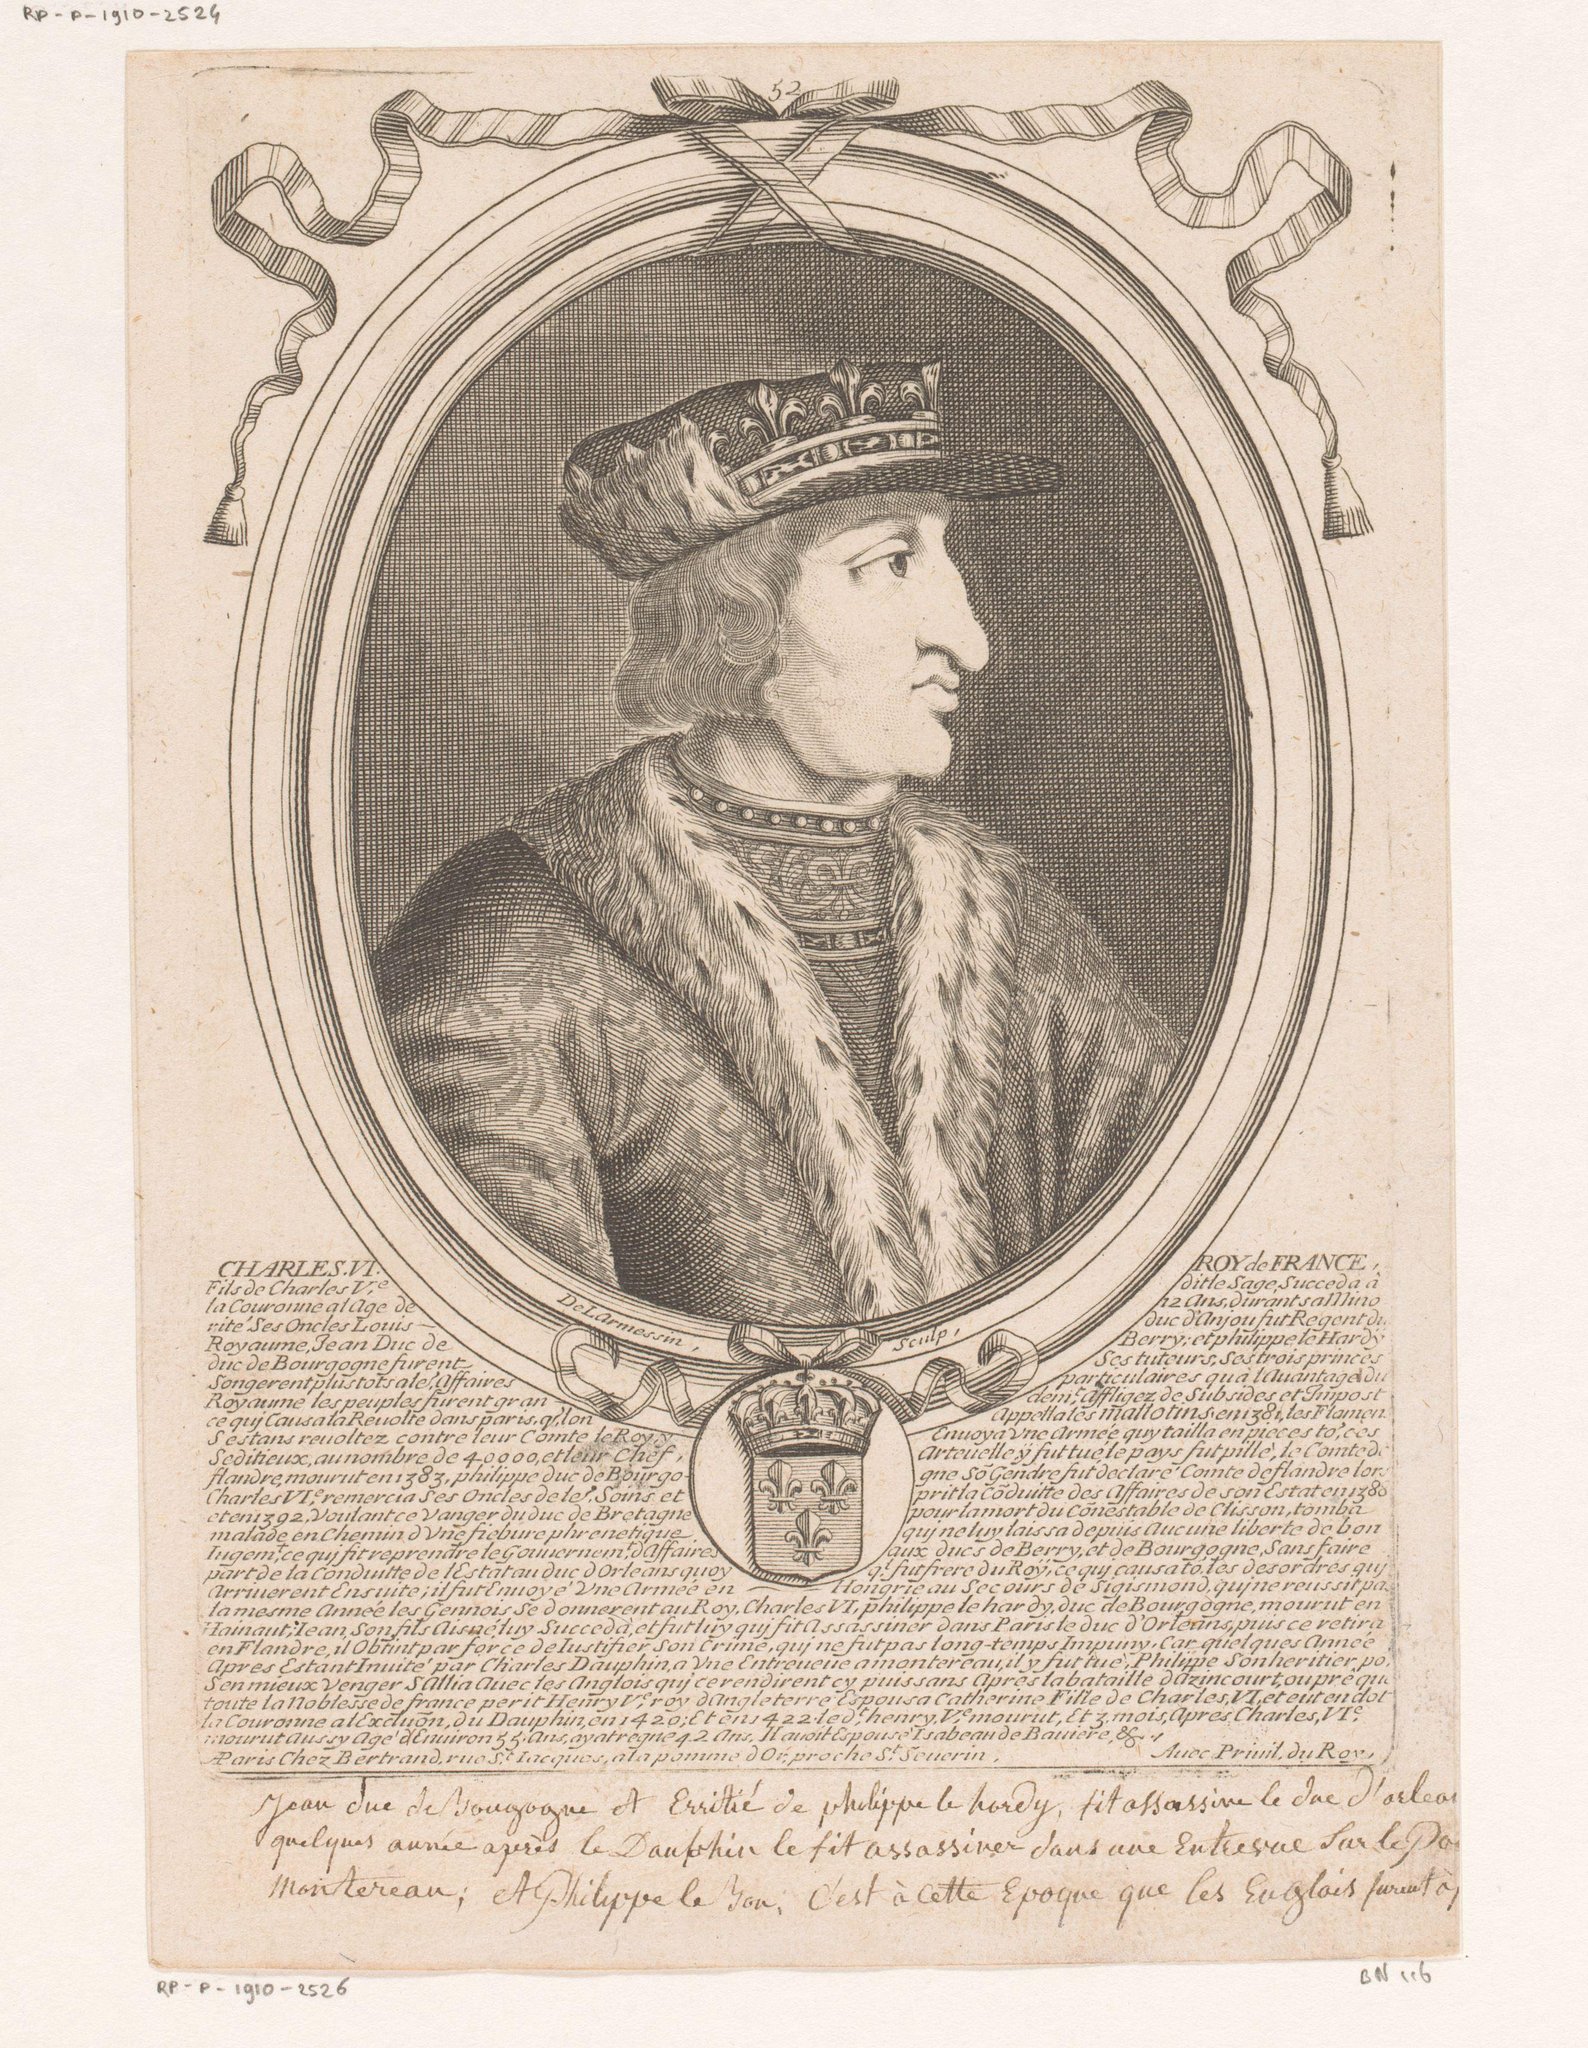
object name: print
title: Portretten van prominente figuren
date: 1642-1678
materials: paper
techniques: engraving, etching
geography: paris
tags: historical persons, king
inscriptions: inscription: ‘Jean duc de Bougogne et (...)’, collector's mark: Lugt 2228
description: Maakt deel uit van een grootschalige serie met portretten van prominente figuren. Binnen de serie bevindt zich een sectie getiteld 'Les Augustes Représentations De tous les Roys De France depuis Pharamond Iusqu'à Louys XIIII'. De serie werd respectievelijk uitgegeven door Pierre Bertrand, door zijn weduwe en door De Larmessin zelf.